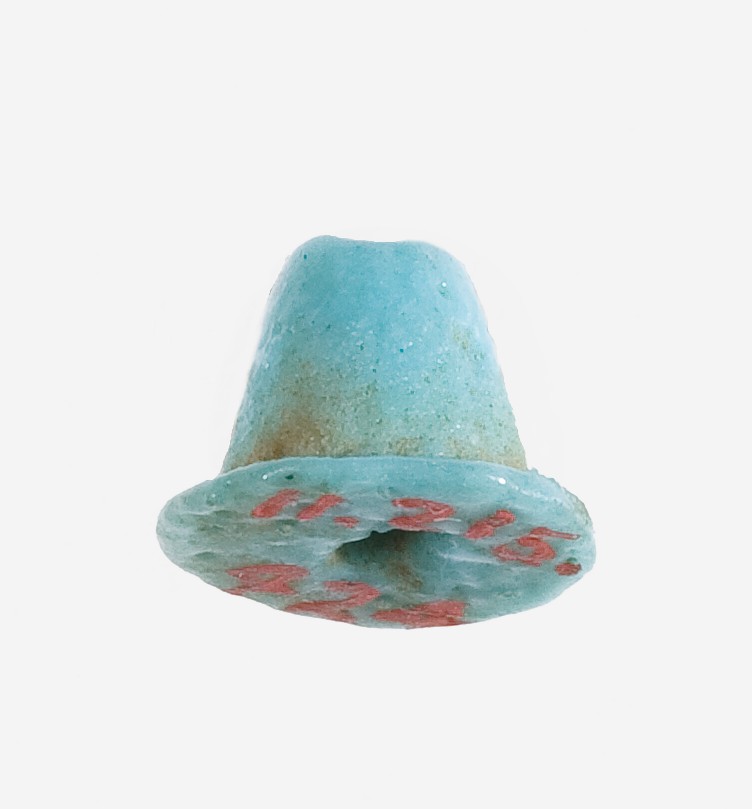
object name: pendant, umbel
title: Umbel Pendant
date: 1390-1352 BCE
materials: faience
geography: egypt